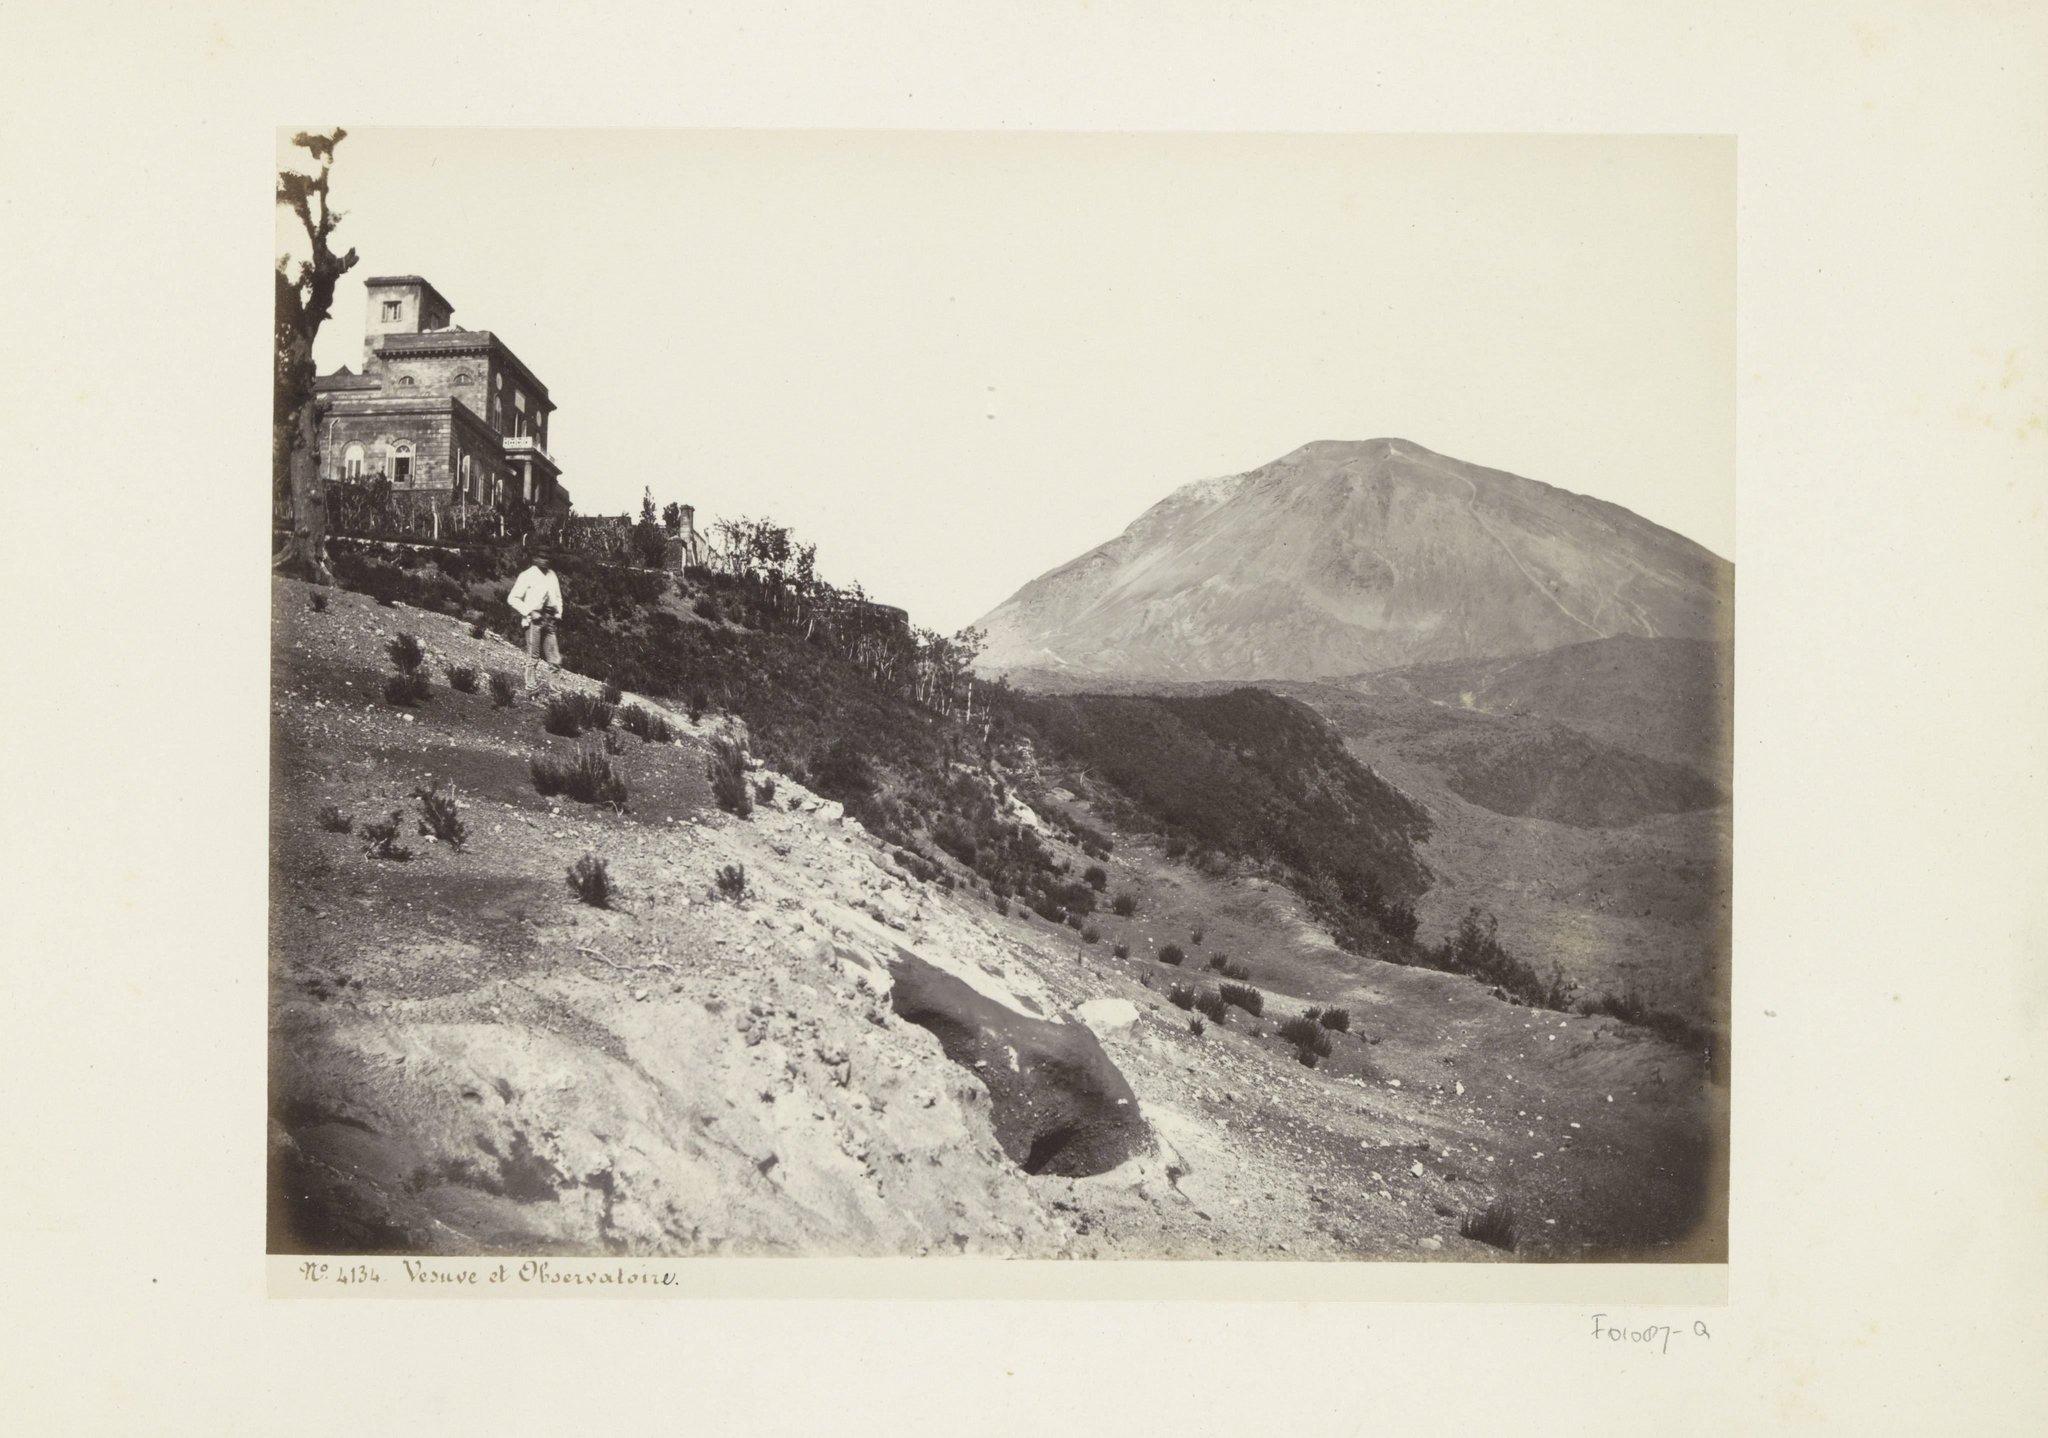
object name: photograph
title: Man poserend voor het observatorium op de flanken van de Vesuvius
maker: Anonymous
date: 1865-1875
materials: paper, photographic support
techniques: albumen print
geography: mount vesuvius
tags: meteorological observatory (+ variant), volcano, mount vesuvius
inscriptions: negative number: ‘4134’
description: Onderdeel van Reisalbum met foto's van bezienswaardigheden in Napels en omgeving.